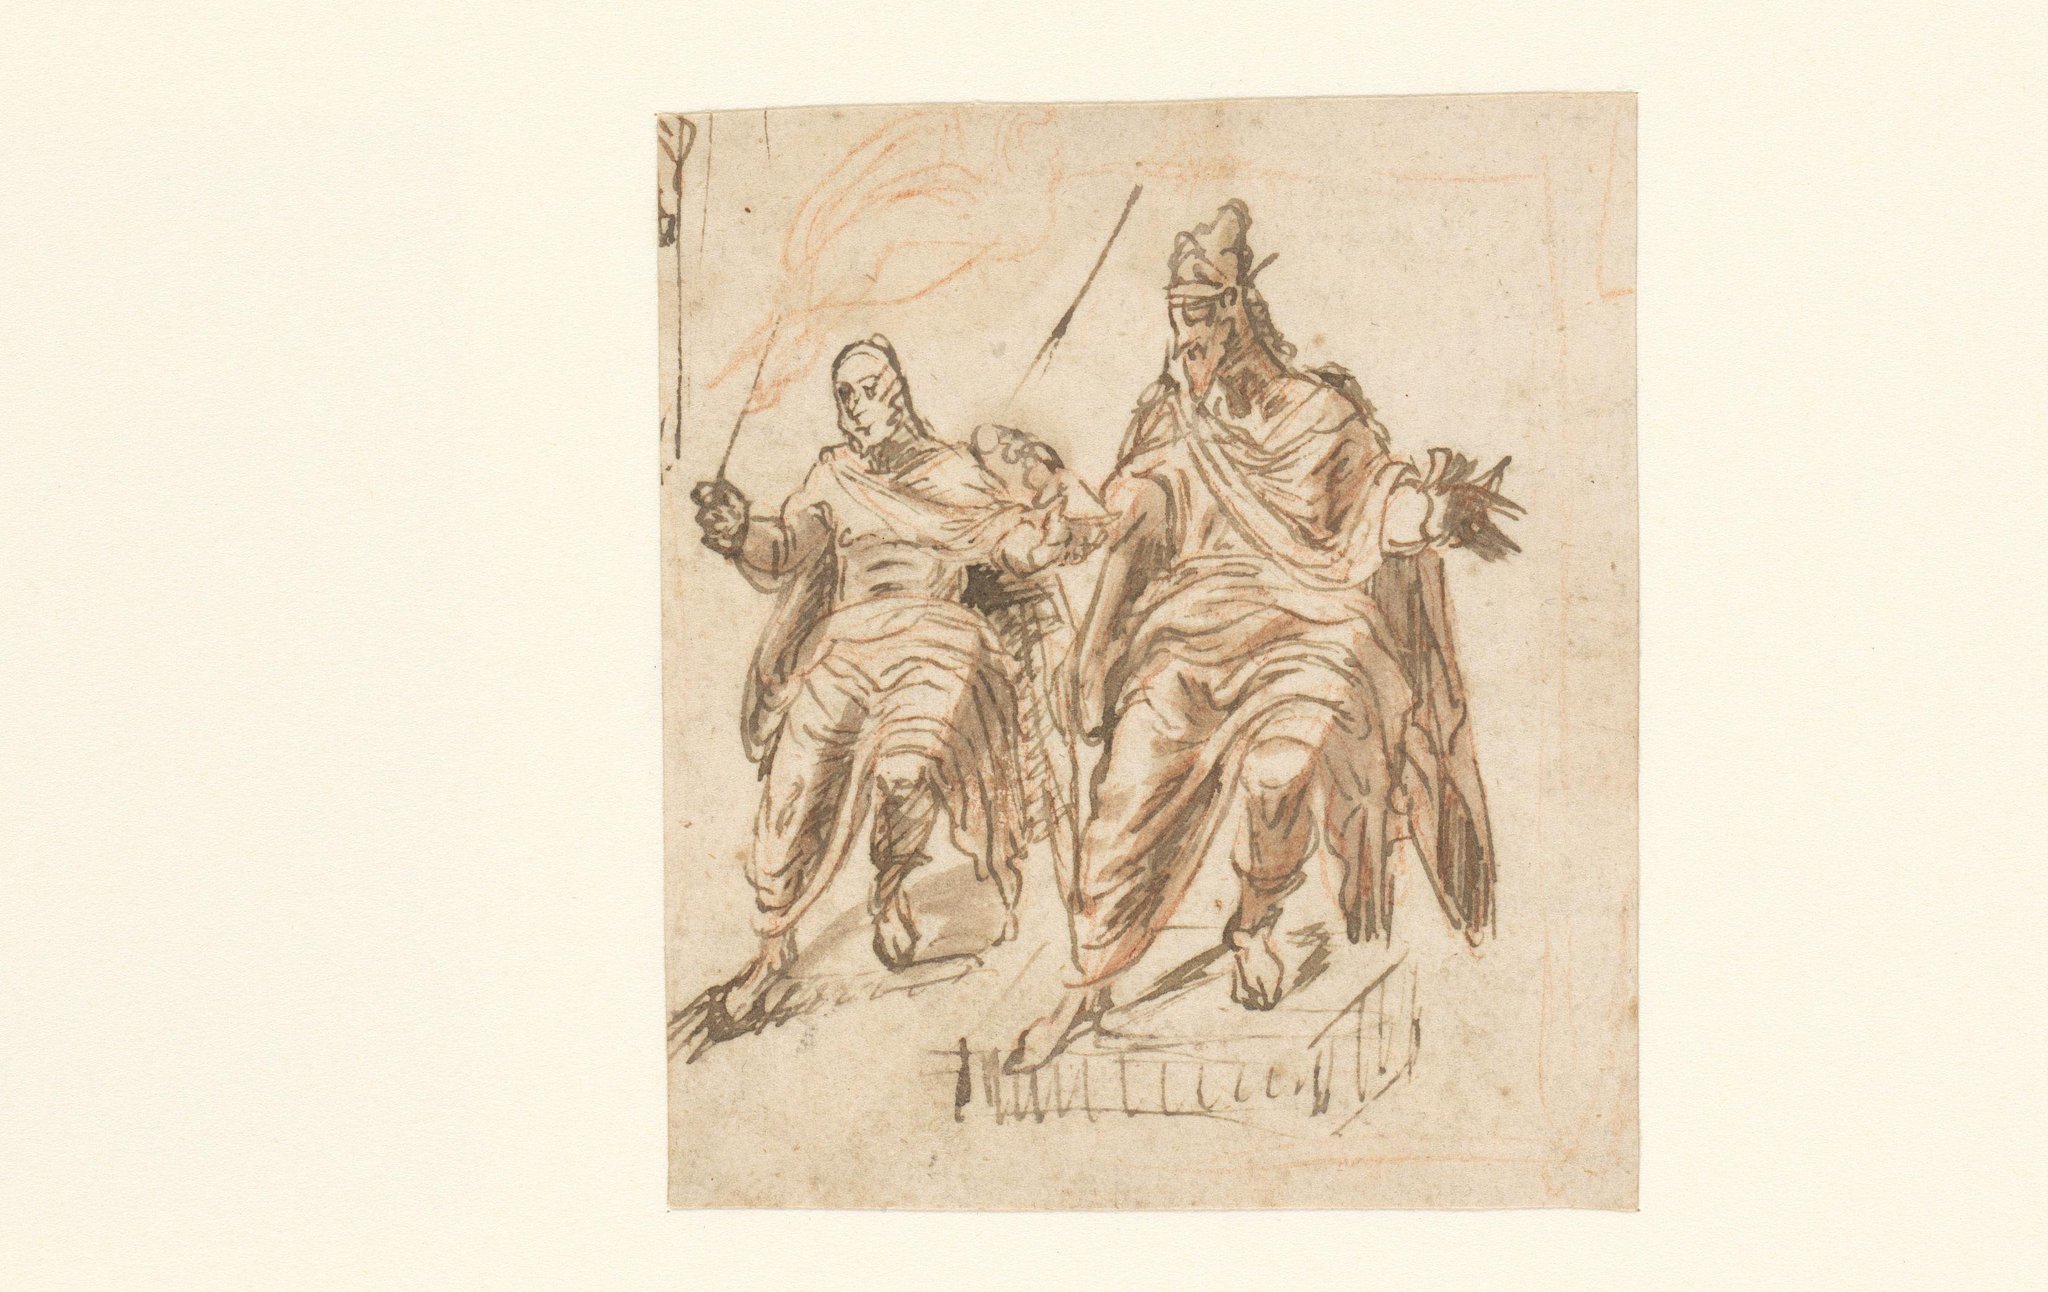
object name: drawing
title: Studie van een zittende vorst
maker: lambert lombard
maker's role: draughtsman, print maker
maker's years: 1505-1566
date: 1516-1566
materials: chalk, ink, paper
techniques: brush, pen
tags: sitting figure, ruler, sovereign